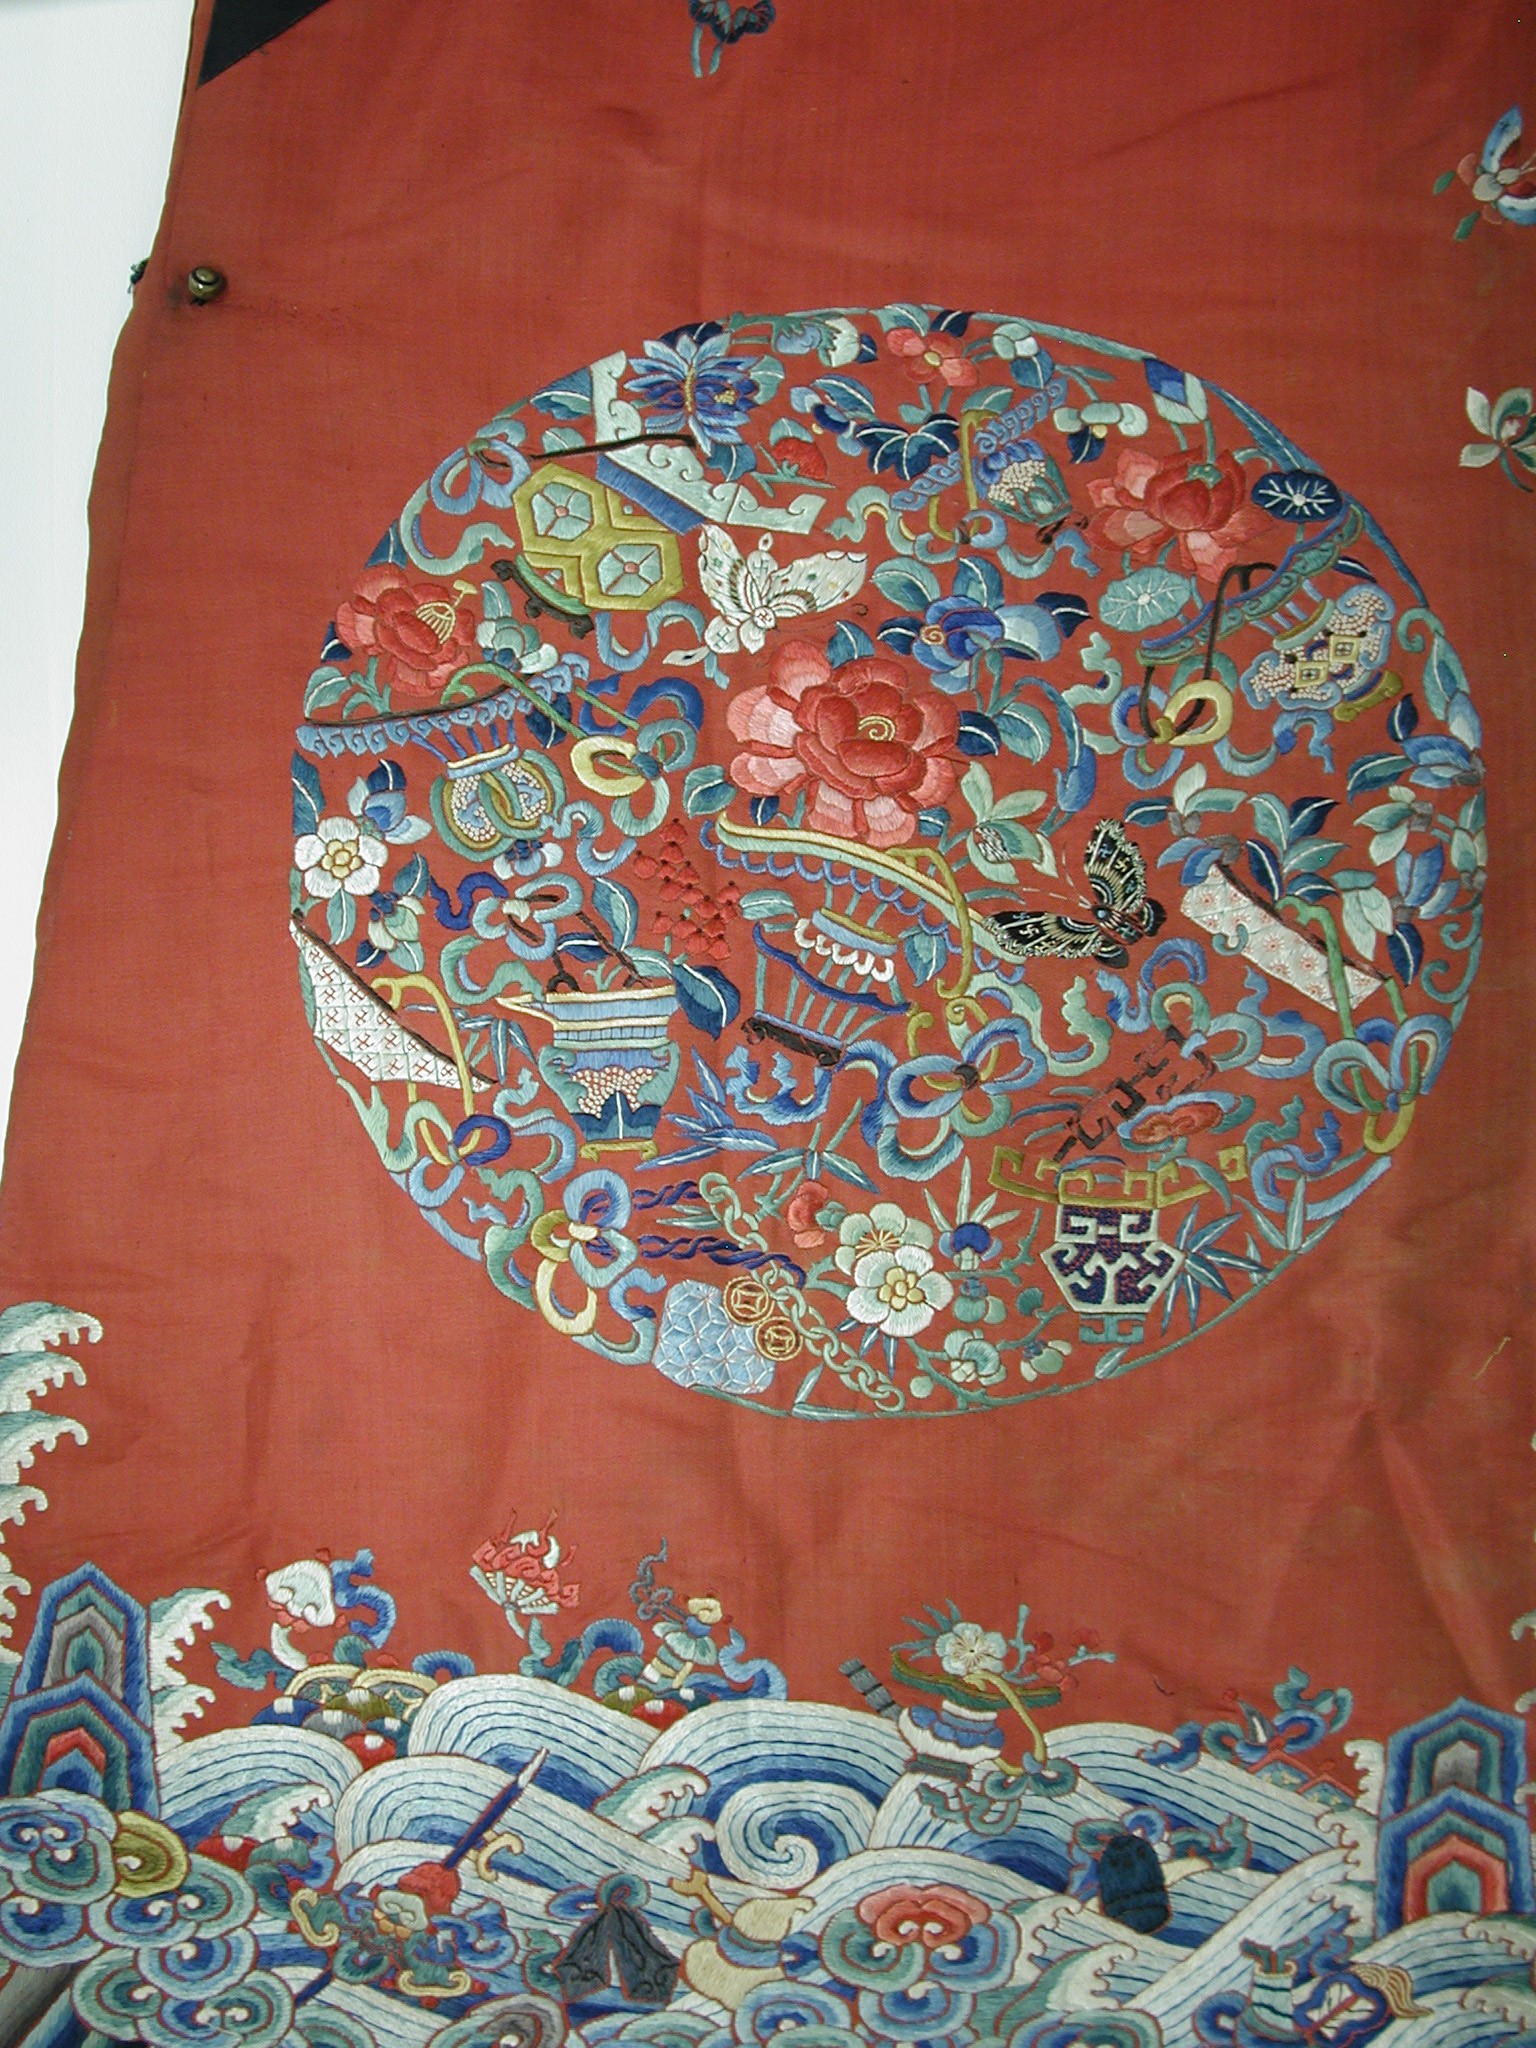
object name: woman's ceremonial robe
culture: chinese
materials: silk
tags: butterflies,flowers